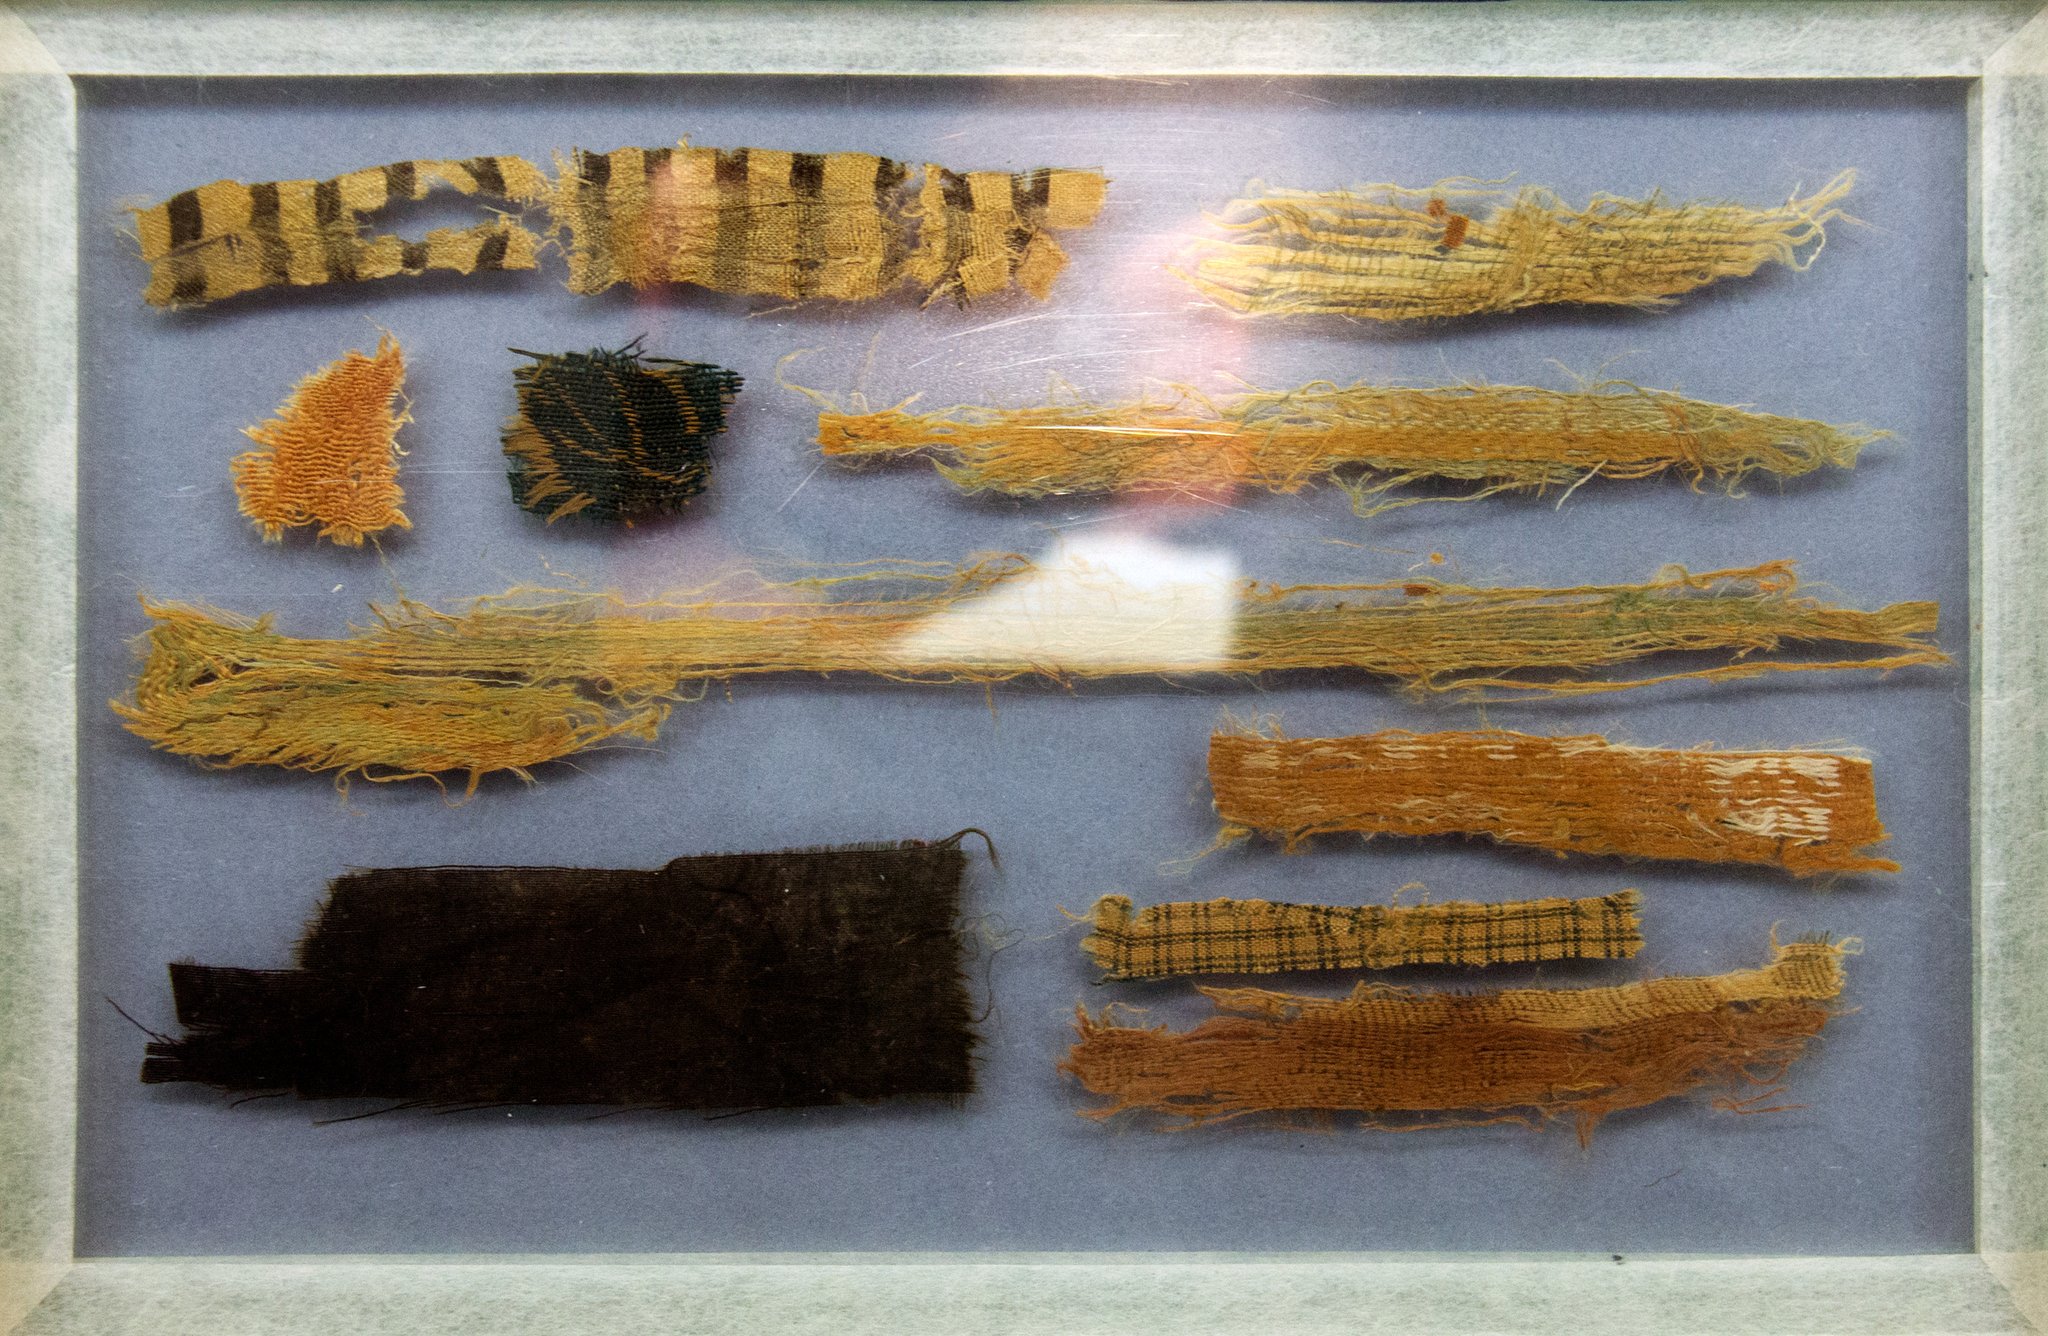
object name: fragment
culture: japanese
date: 701-800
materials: textile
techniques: weave